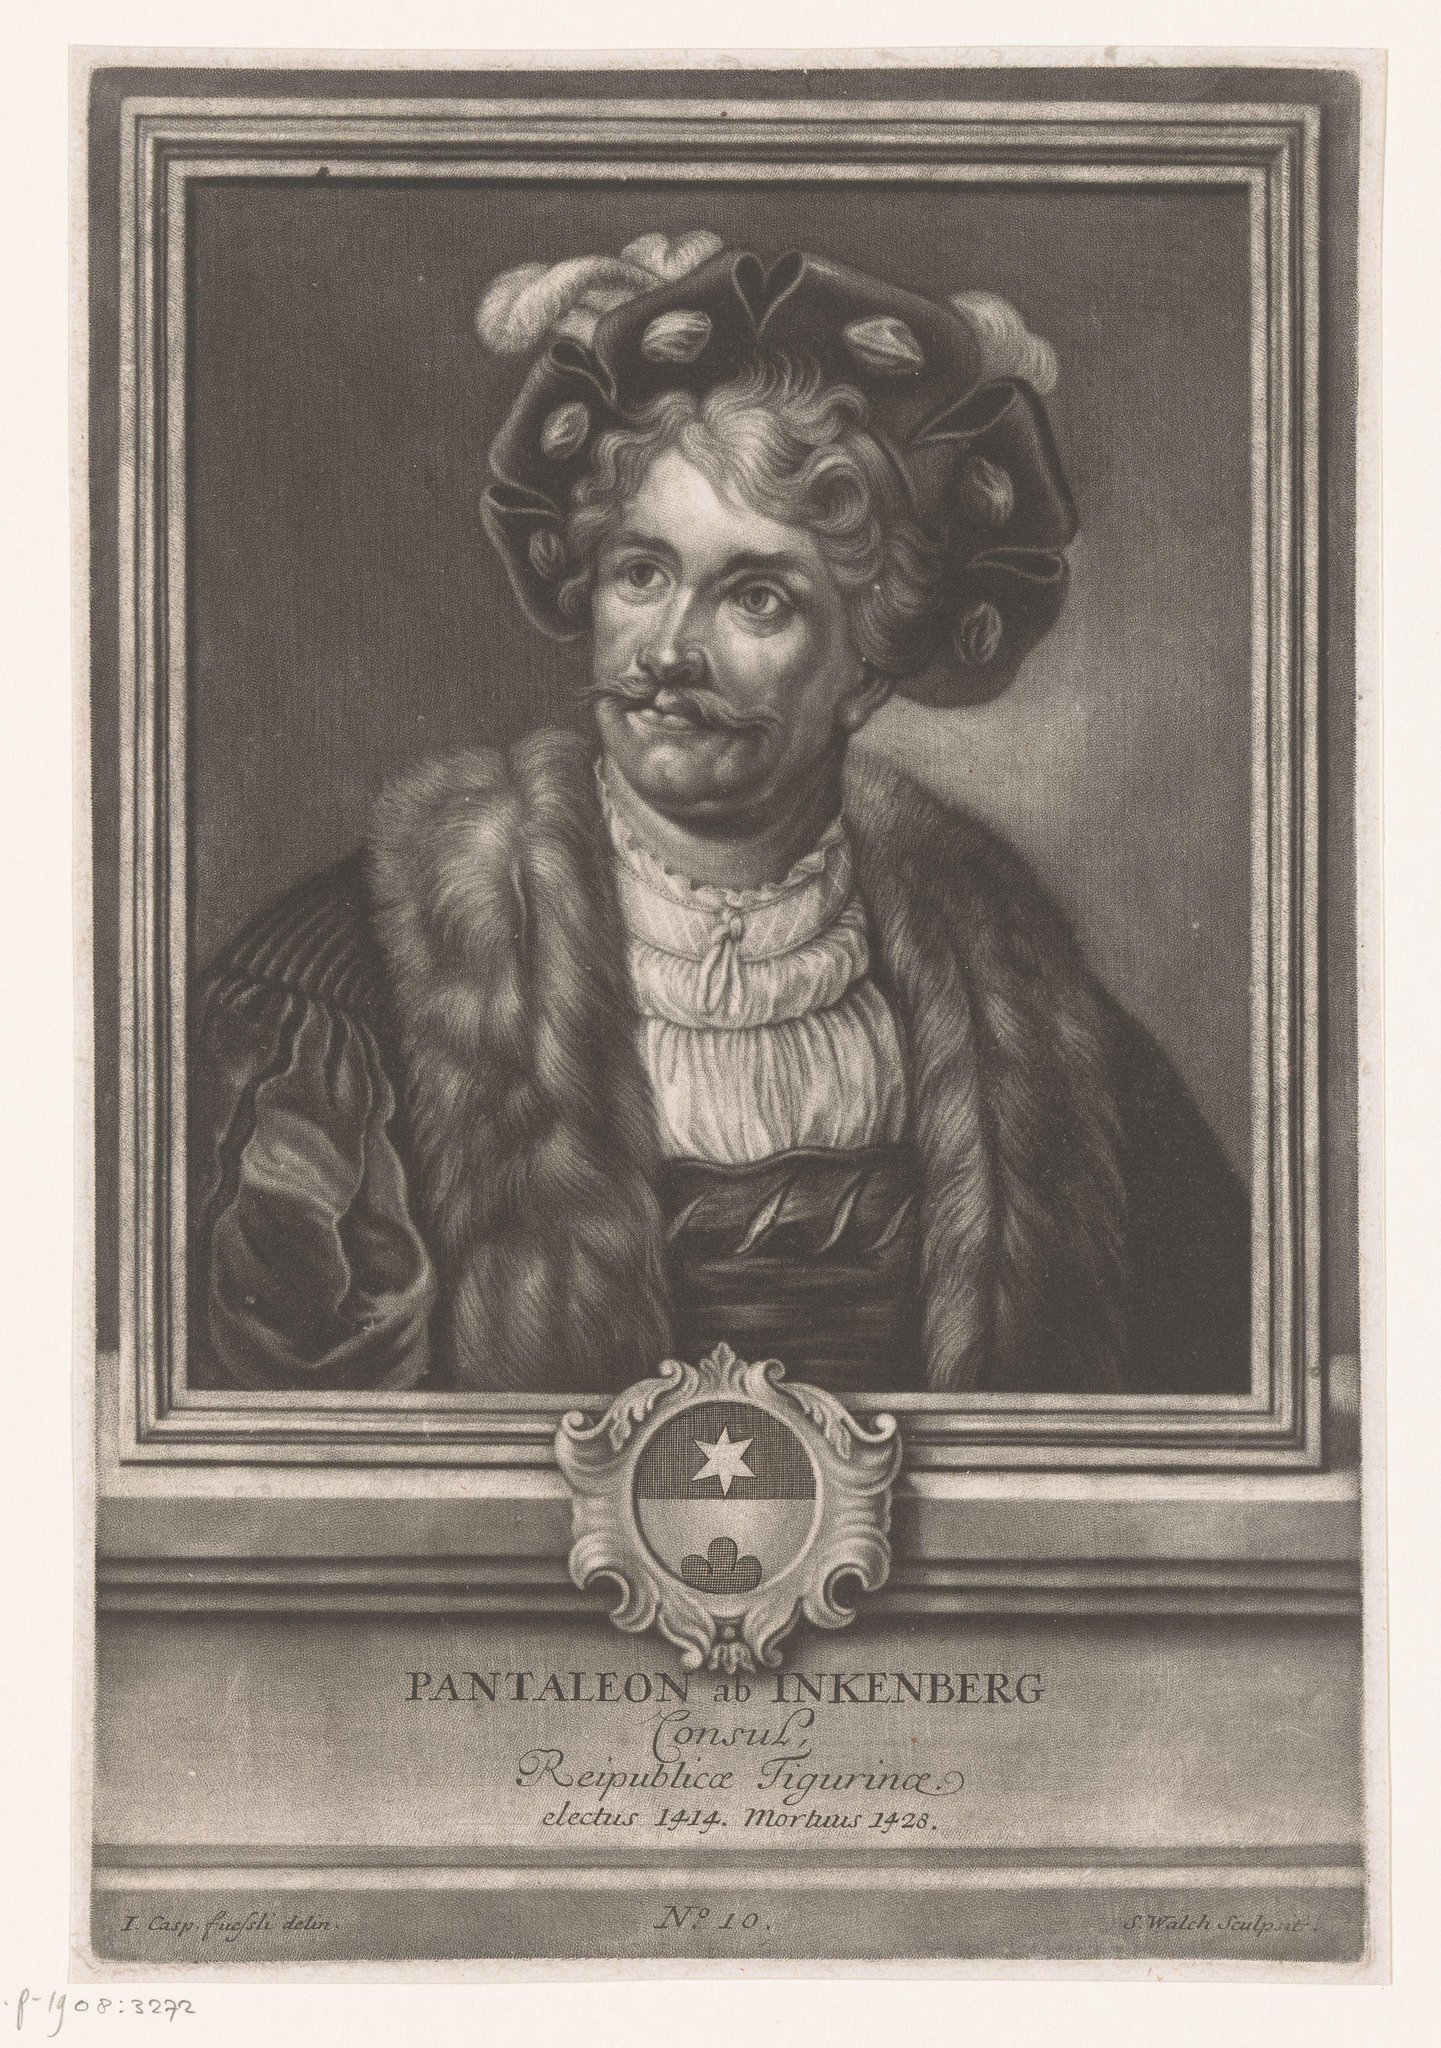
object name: print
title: Portret van Pantaleon ab Inkenberg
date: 1731-1788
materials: paper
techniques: mezzotint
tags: mayor, historical persons, armorial bearing, heraldry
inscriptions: collector's mark: Lugt 2228